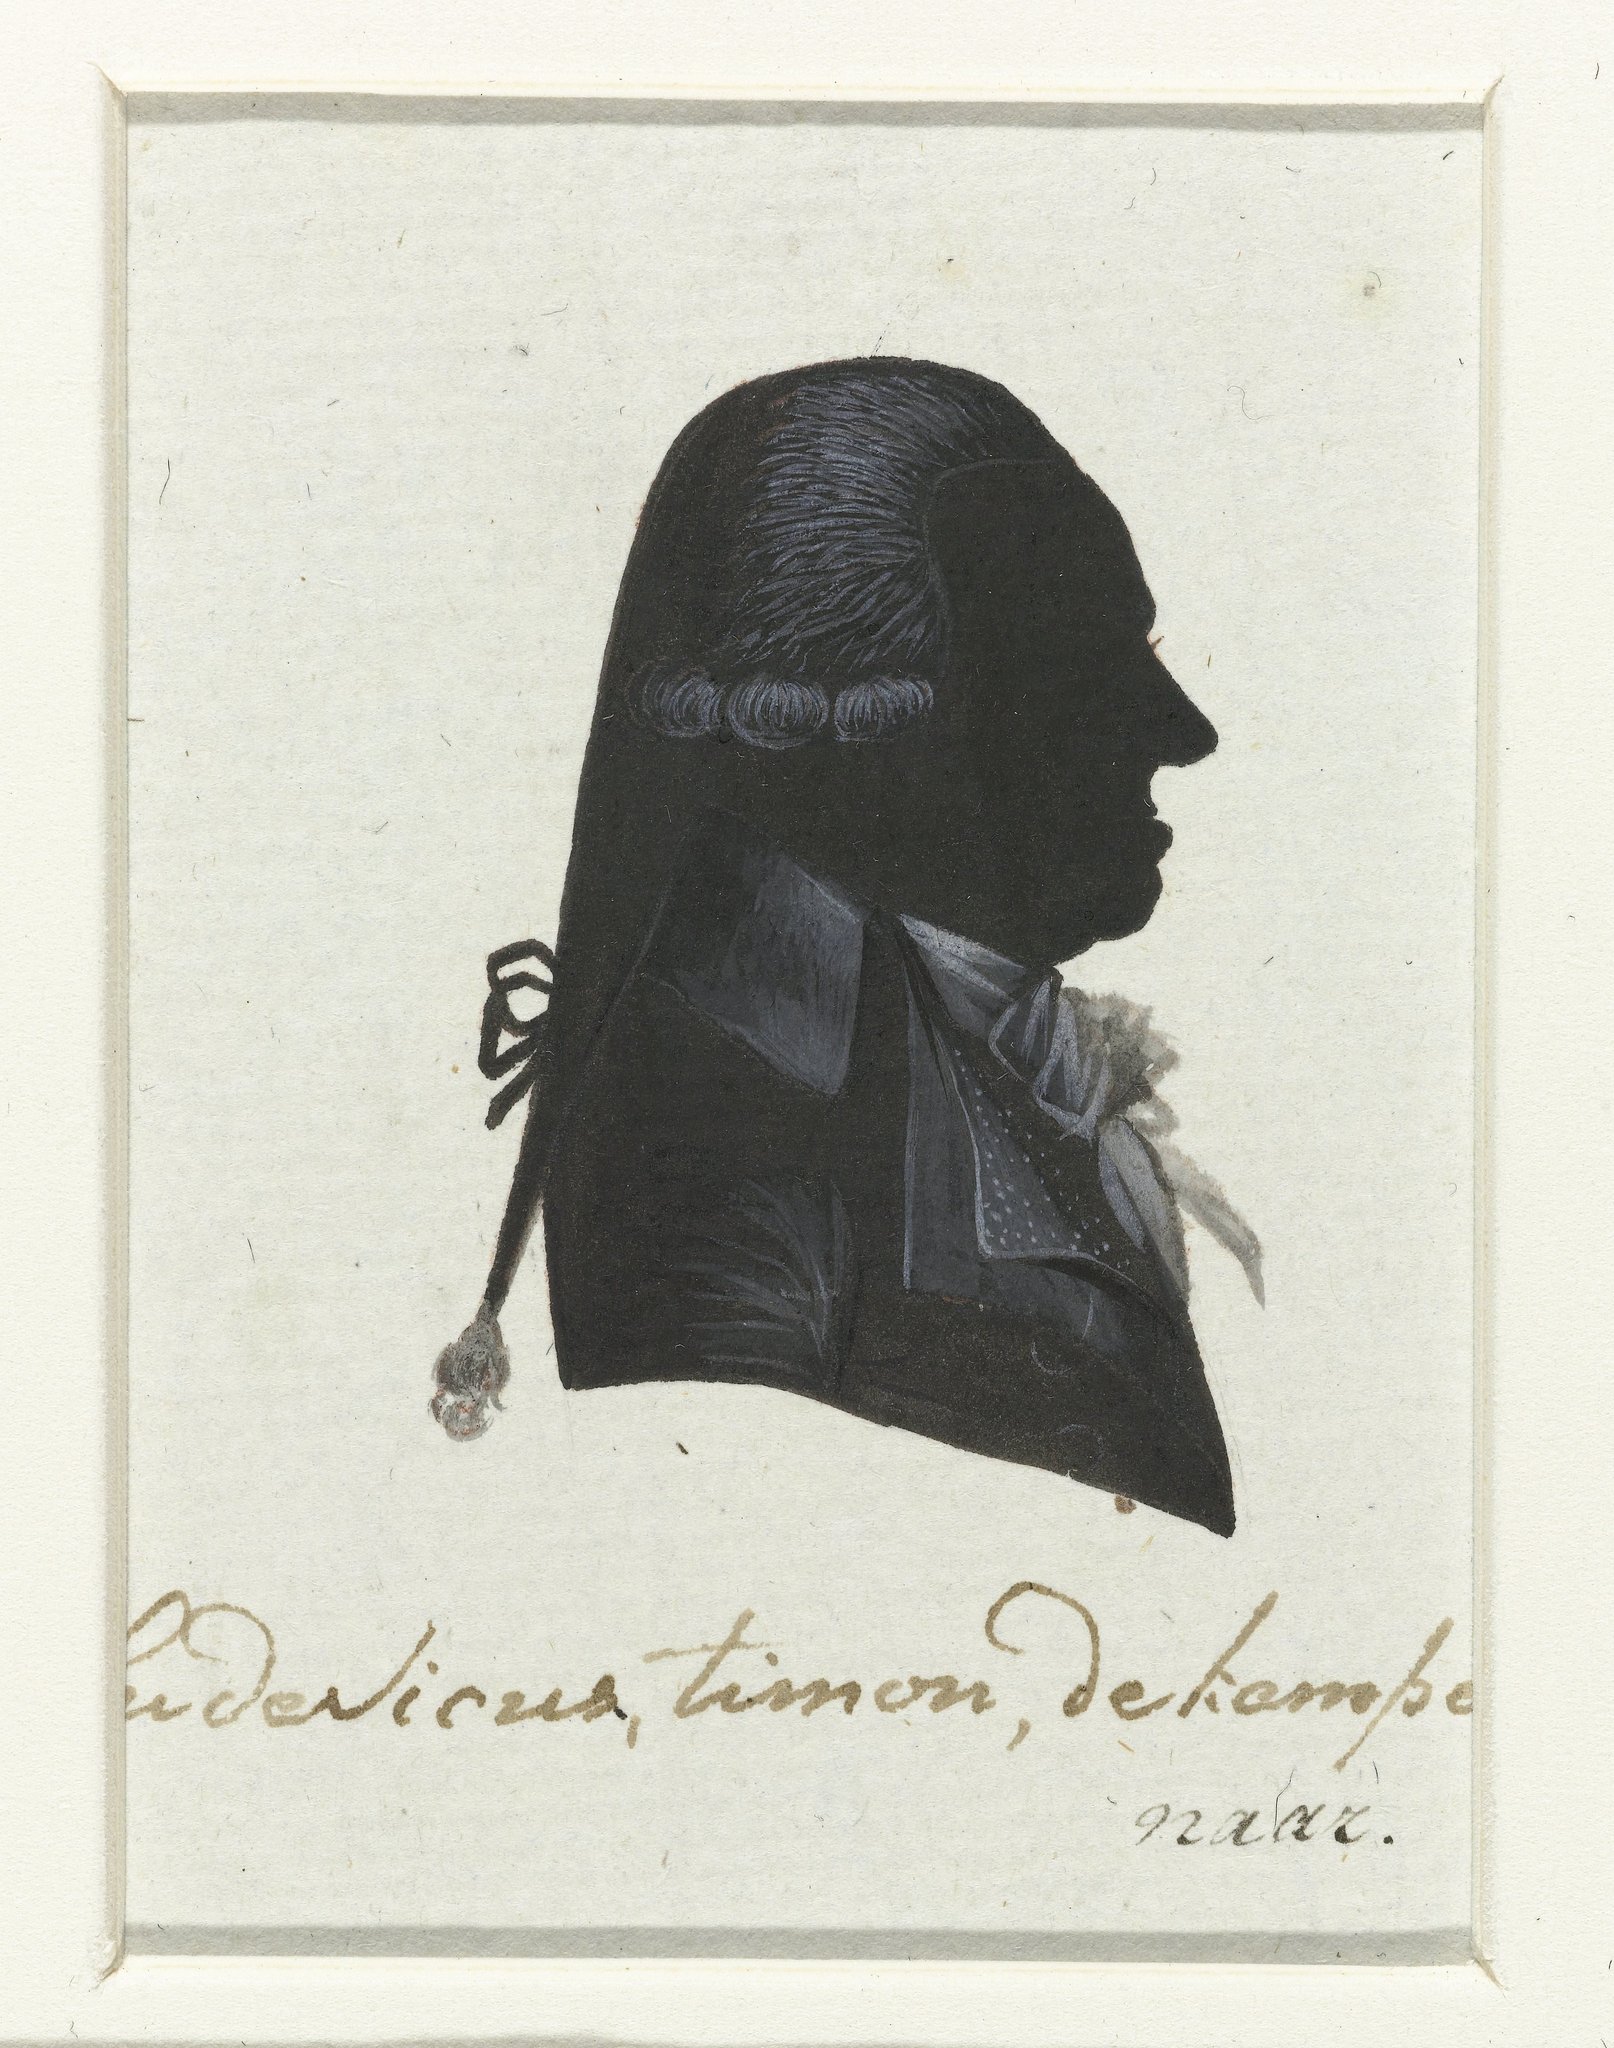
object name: silhouette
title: Representanten van de eerste Nationale Vergadering van de Bataafse Republiek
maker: hausdorff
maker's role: draughtsman, print maker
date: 1796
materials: ink, paper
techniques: drawing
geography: netherlands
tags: historical persons (+ profile portrait), the hague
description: Silhouettes of members of the National Assembly. India ink on paper, 1796. Early in 1795 Stadholder William V fled to England. In the Republic a new regime was installed. A year later, the country held its first general election. Every Dutch man over the age of twenty and not on poor relief was entitled to vote for a candidate to the National Assembly, the parliament of the Batavian Republic, as the country was known between 1795 and 1806. The 126 representatives who sat in the assembly were drawn from the educated, progressive elite of Dutch society.